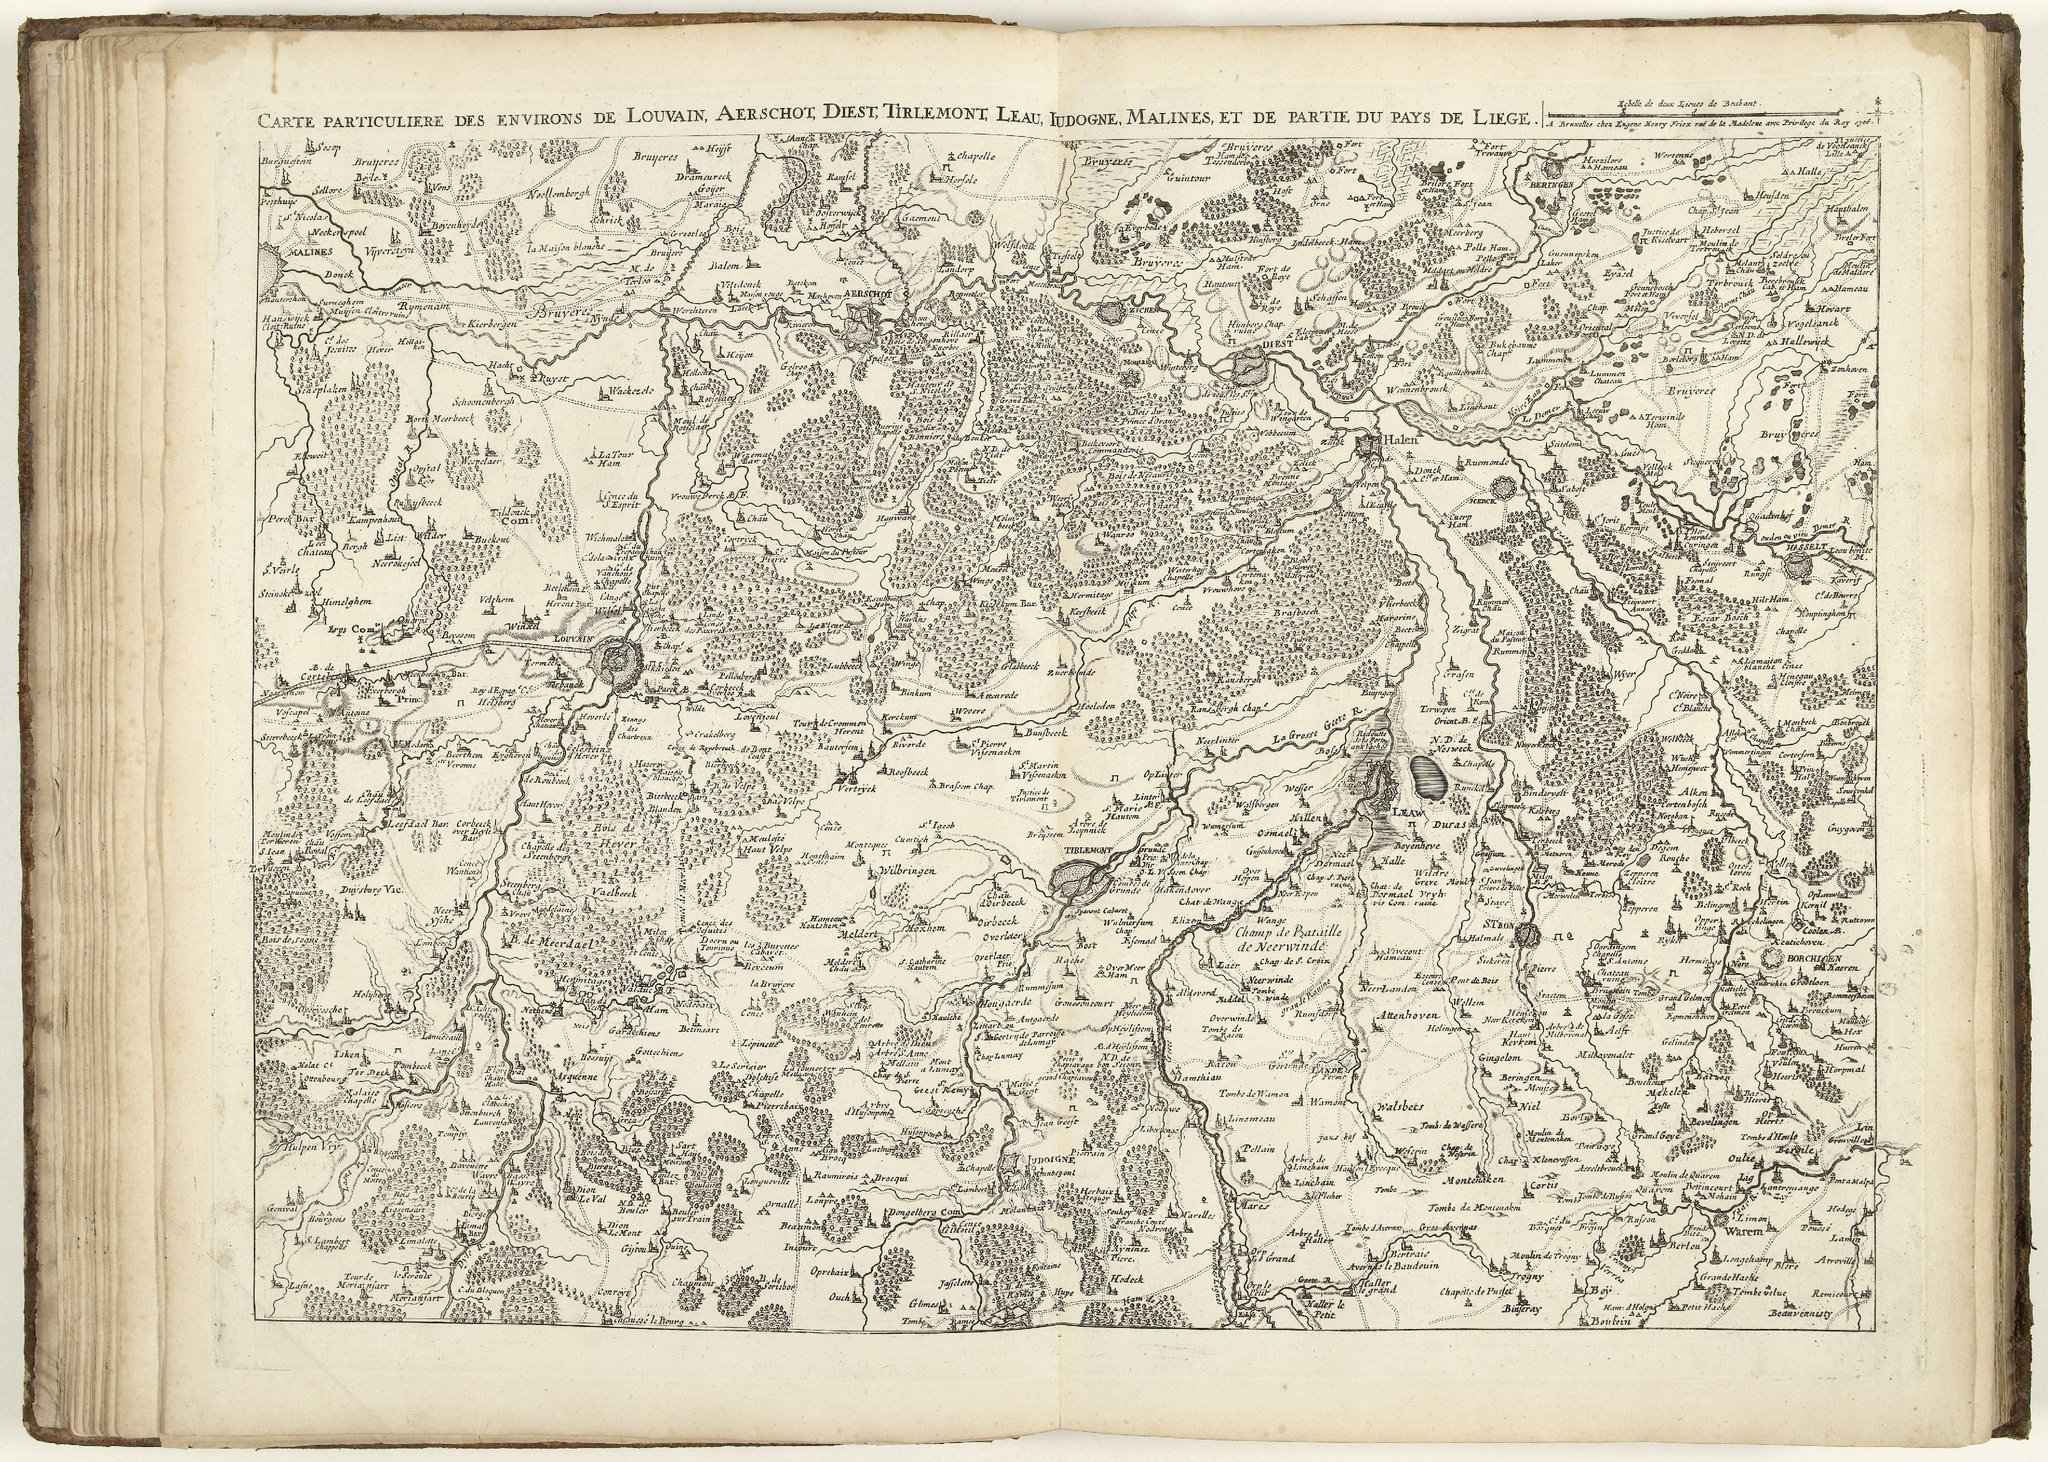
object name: print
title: Kaart van Brabant, 1706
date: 1706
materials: paper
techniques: engraving, etching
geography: brussels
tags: maps of separate countries or regions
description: Kaart van een deel van Vlaams-Brabant met de steden Leuven, Aarschot, Diest, Tienen, Zoutleeuw, Jodoigne, Mechelen en een deel van het land van Luik, 1706. Onderdeel van een gebundelde verzameling van plannen van veldslagen en steden vermaard in de Spaanse Successieoorlog. Deze plaat behoort tot de eerste 24 platen die samen een zeer grote kaart van de Zuidelijke Nederlanden vormen.